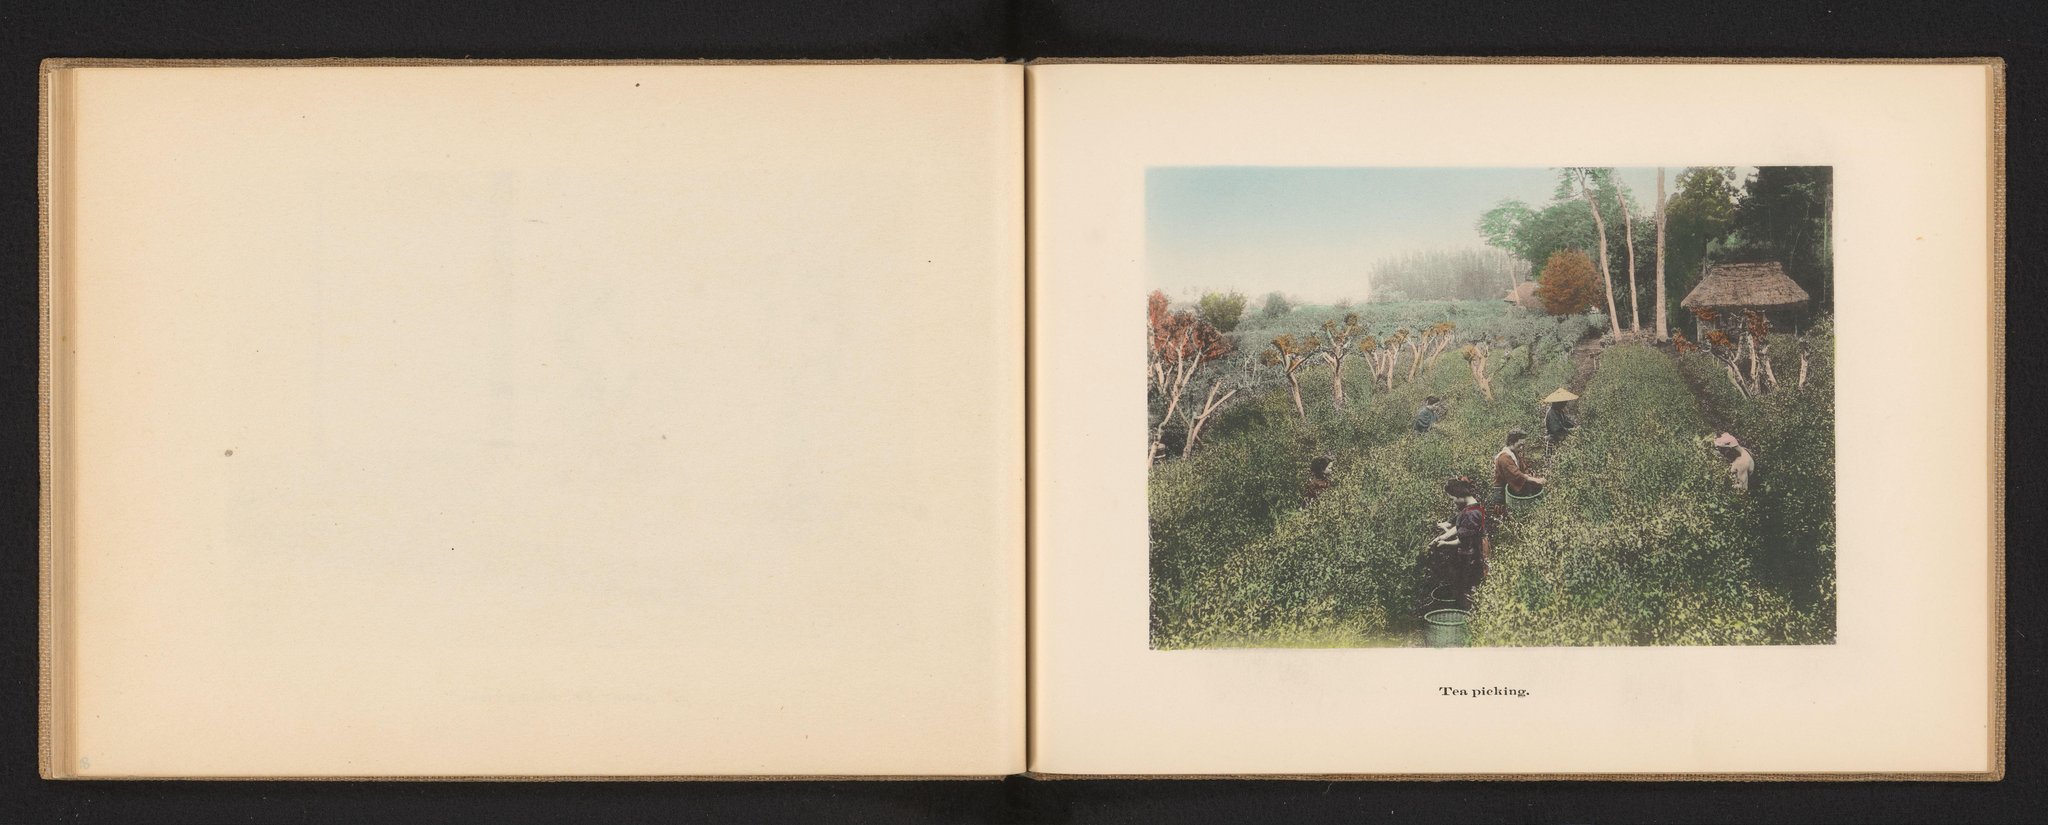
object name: photomechanical print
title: Tea picking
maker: kōzaburō tamamura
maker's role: fotograaf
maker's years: 1856-1923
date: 1895-1905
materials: paper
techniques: photograph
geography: japan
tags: tea (leaves), japan